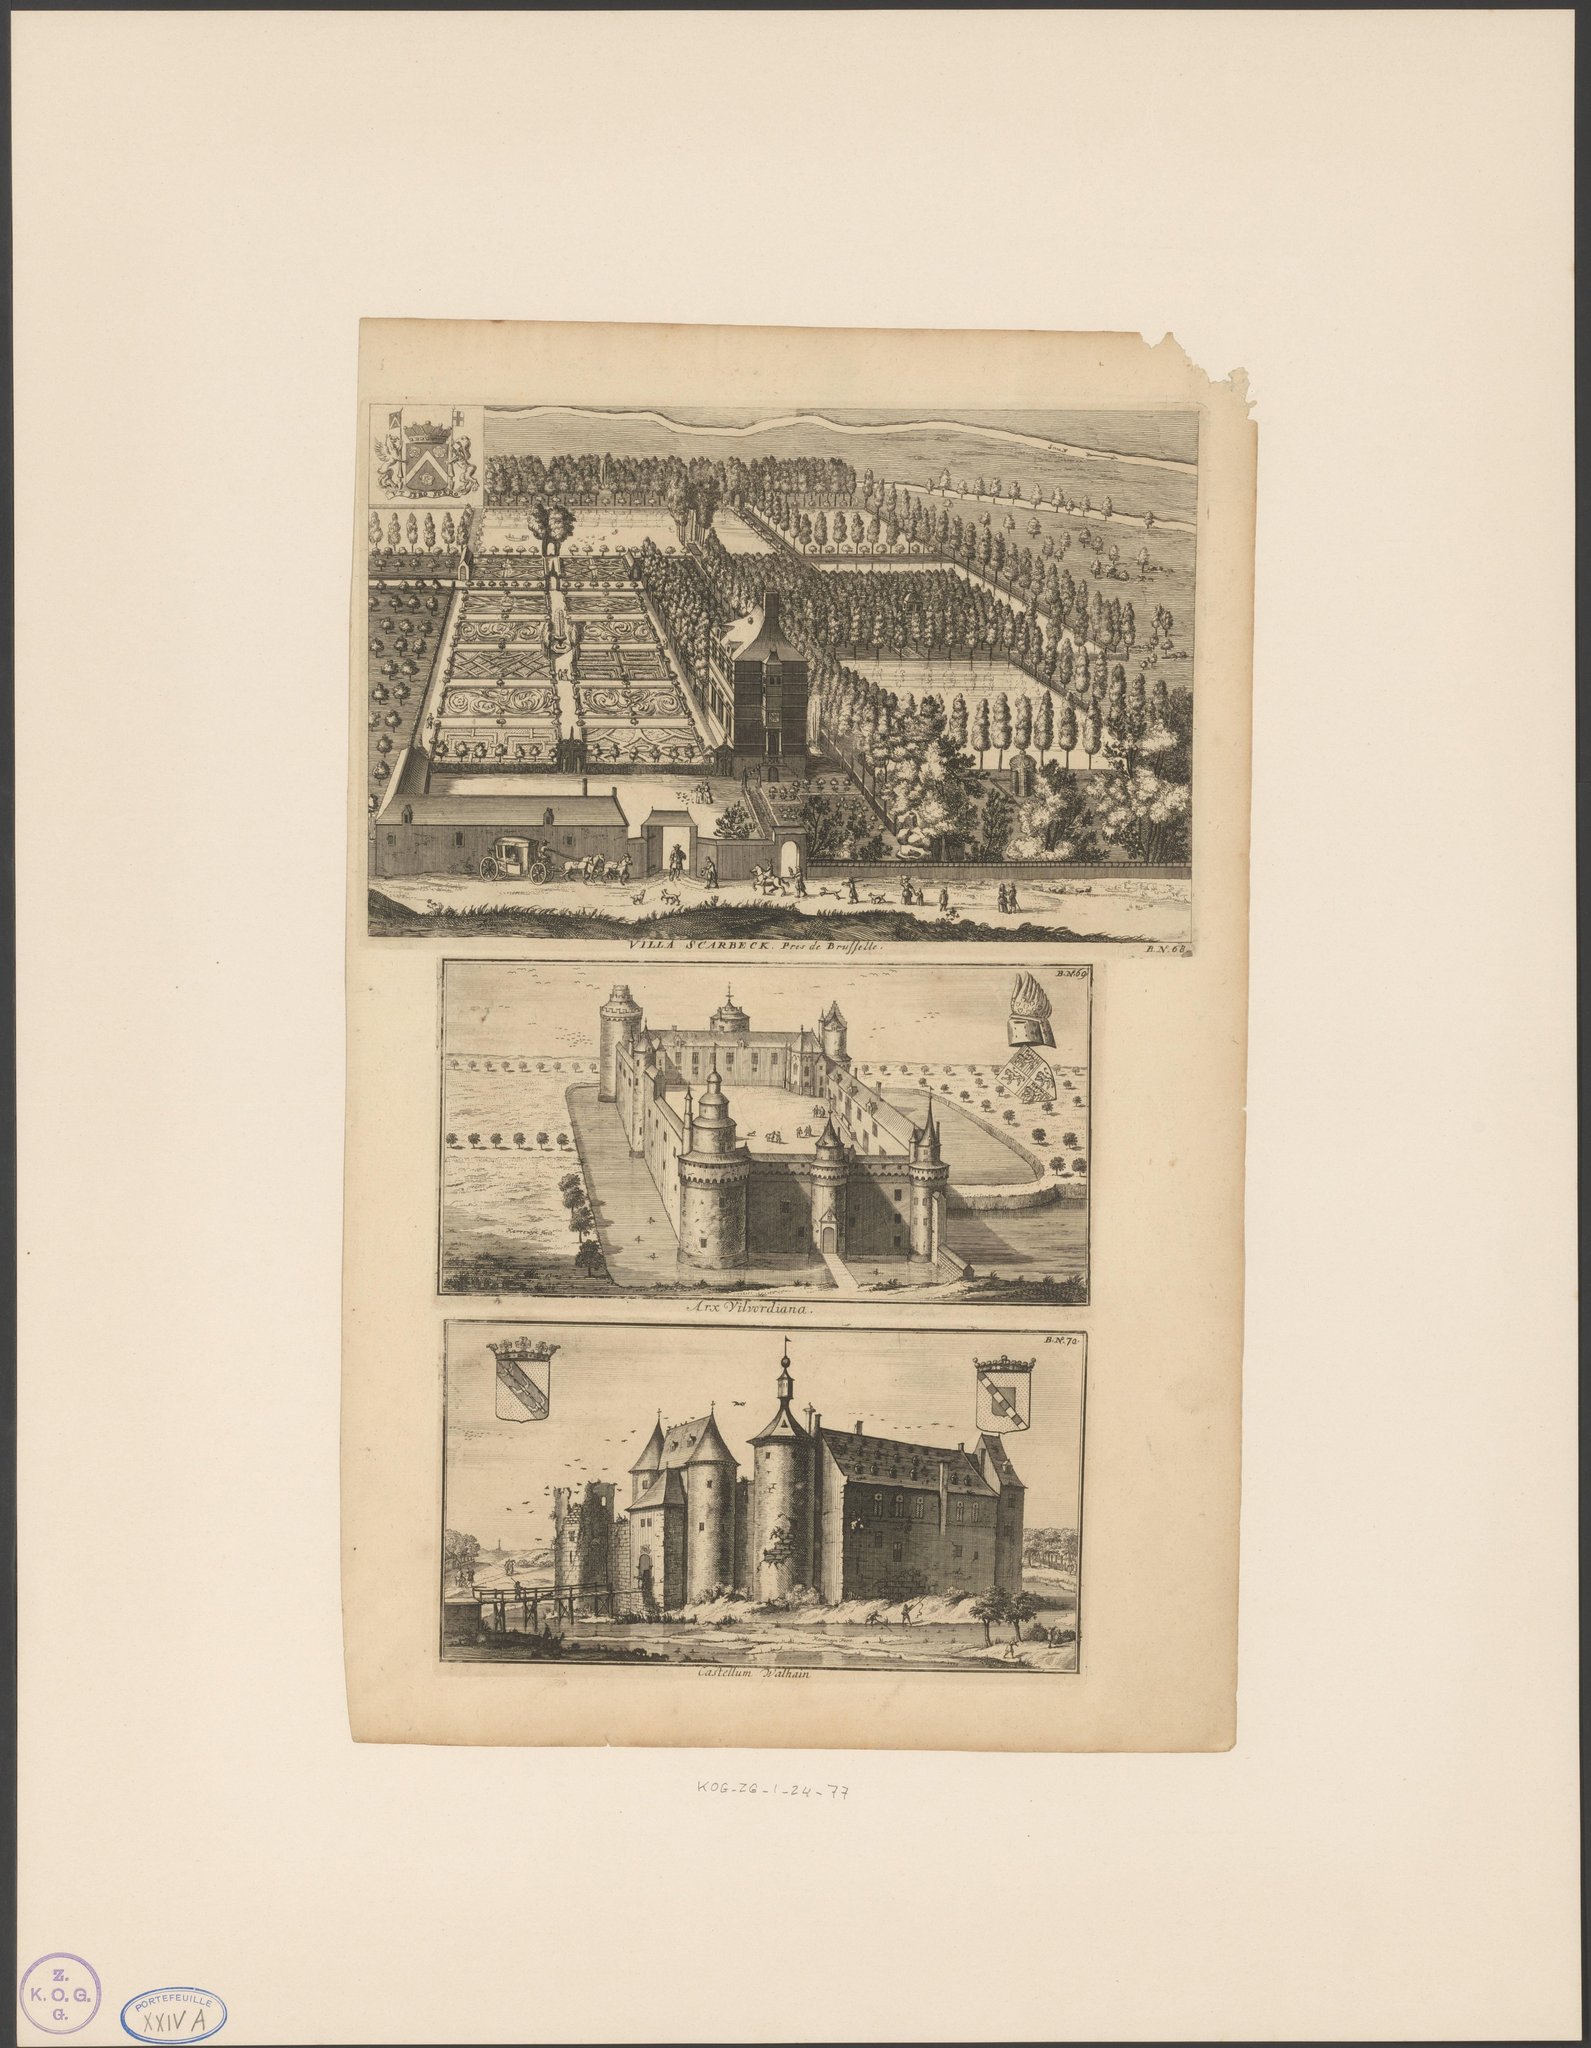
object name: print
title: Gezichten op Kasteel Monplaisir, Kasteel van Vilvoorde, Kasteel van Walhain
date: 1750-1799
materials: paper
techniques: engraving, etching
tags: castle, armorial bearing, heraldry, walloon brabant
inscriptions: collector's mark: Lugt 1641, stamp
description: Bovenste plaat heeft linksboven een wapenschild. De middelste plaat heeft rechtsboven een wapenschild. Onderste plaat heeft links- en rechtsboven een wapenschild. Iedere prent is genummerd: B.No. 68, B.No. 69, B.No. 70. Onderwerpsrubrieken binnen de Atlas Zeden en Gewoonten: Zeden en Gewoonten in Engeren Zin, De Woning. Kastelen en buitenplaatsen. Over de Grenzen.